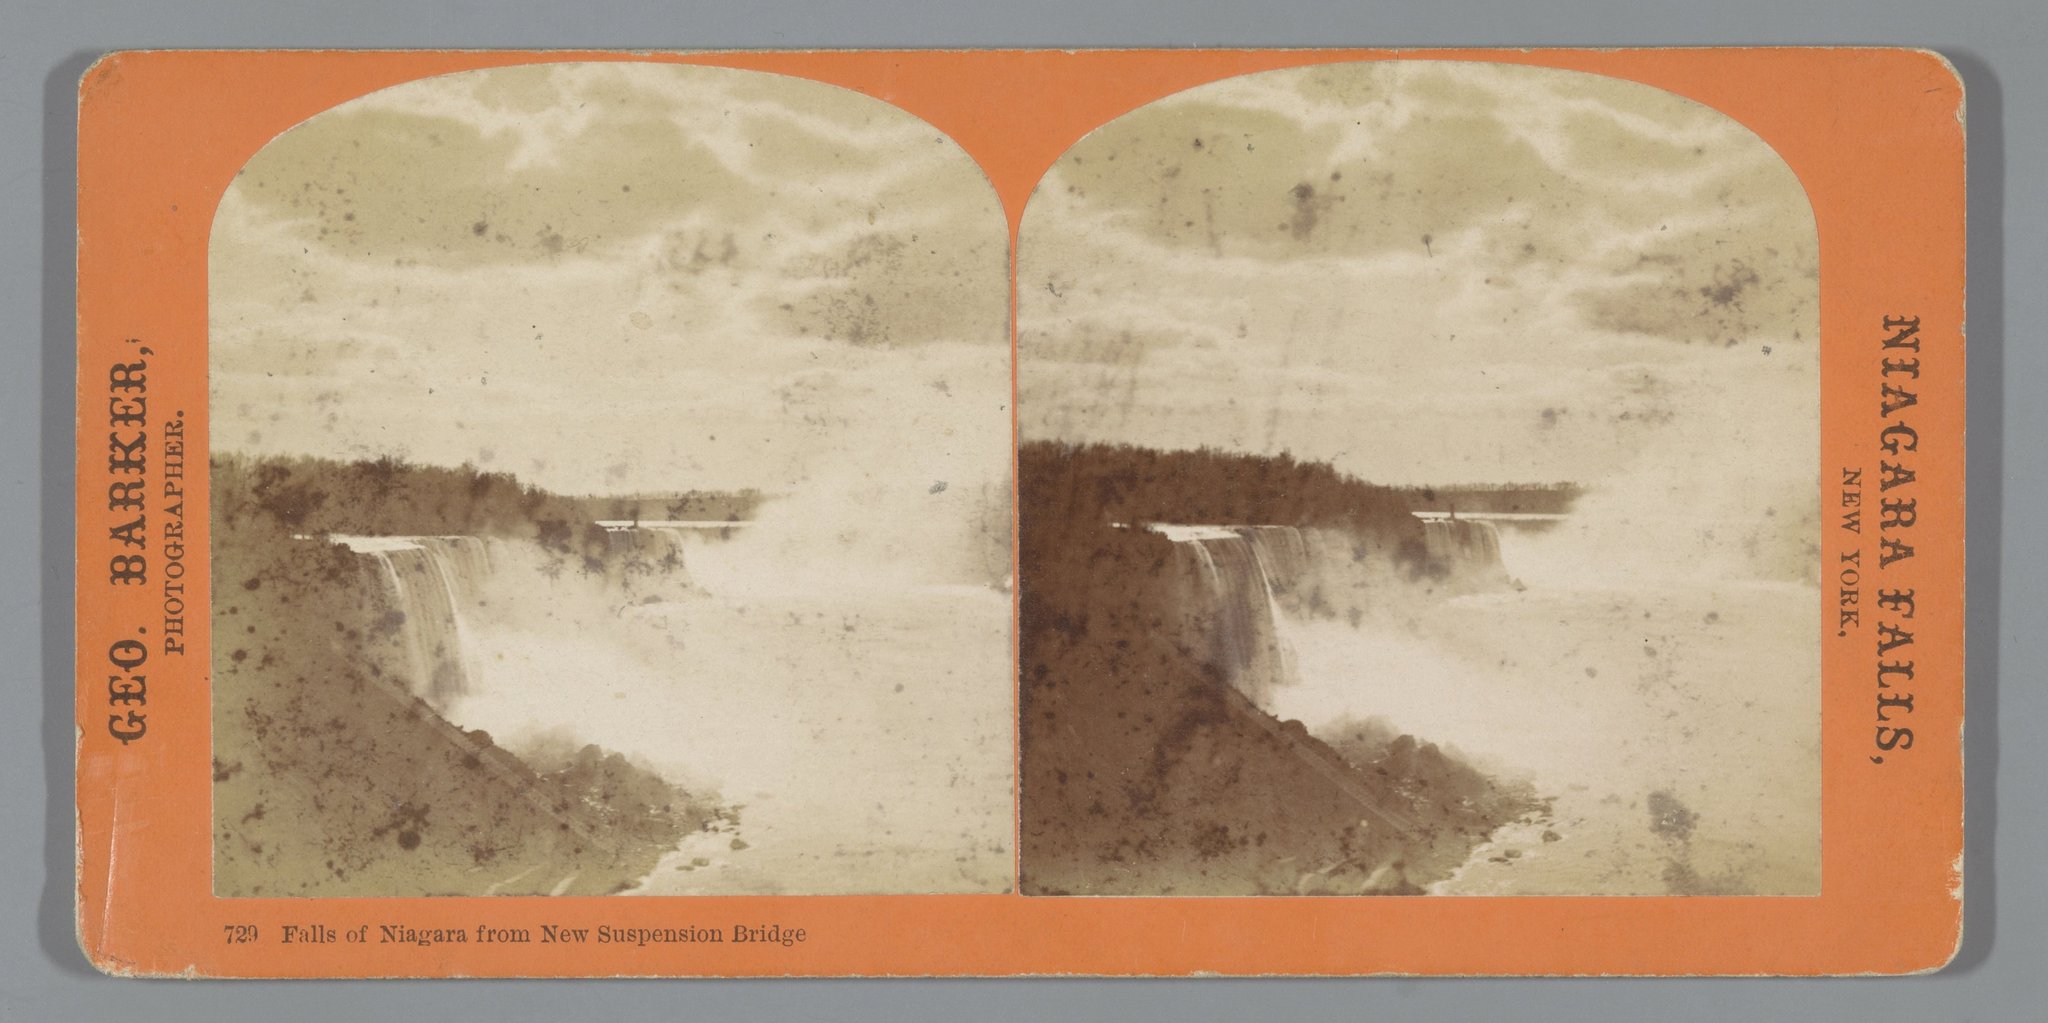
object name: stereograph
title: Niagara Falls, New York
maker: george barker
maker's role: fotograaf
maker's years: 1844-1894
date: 1869-1889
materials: cardboard, paper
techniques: albumen print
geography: niagara clifton bridge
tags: suspension bridge, waterfall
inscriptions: number: ‘729’